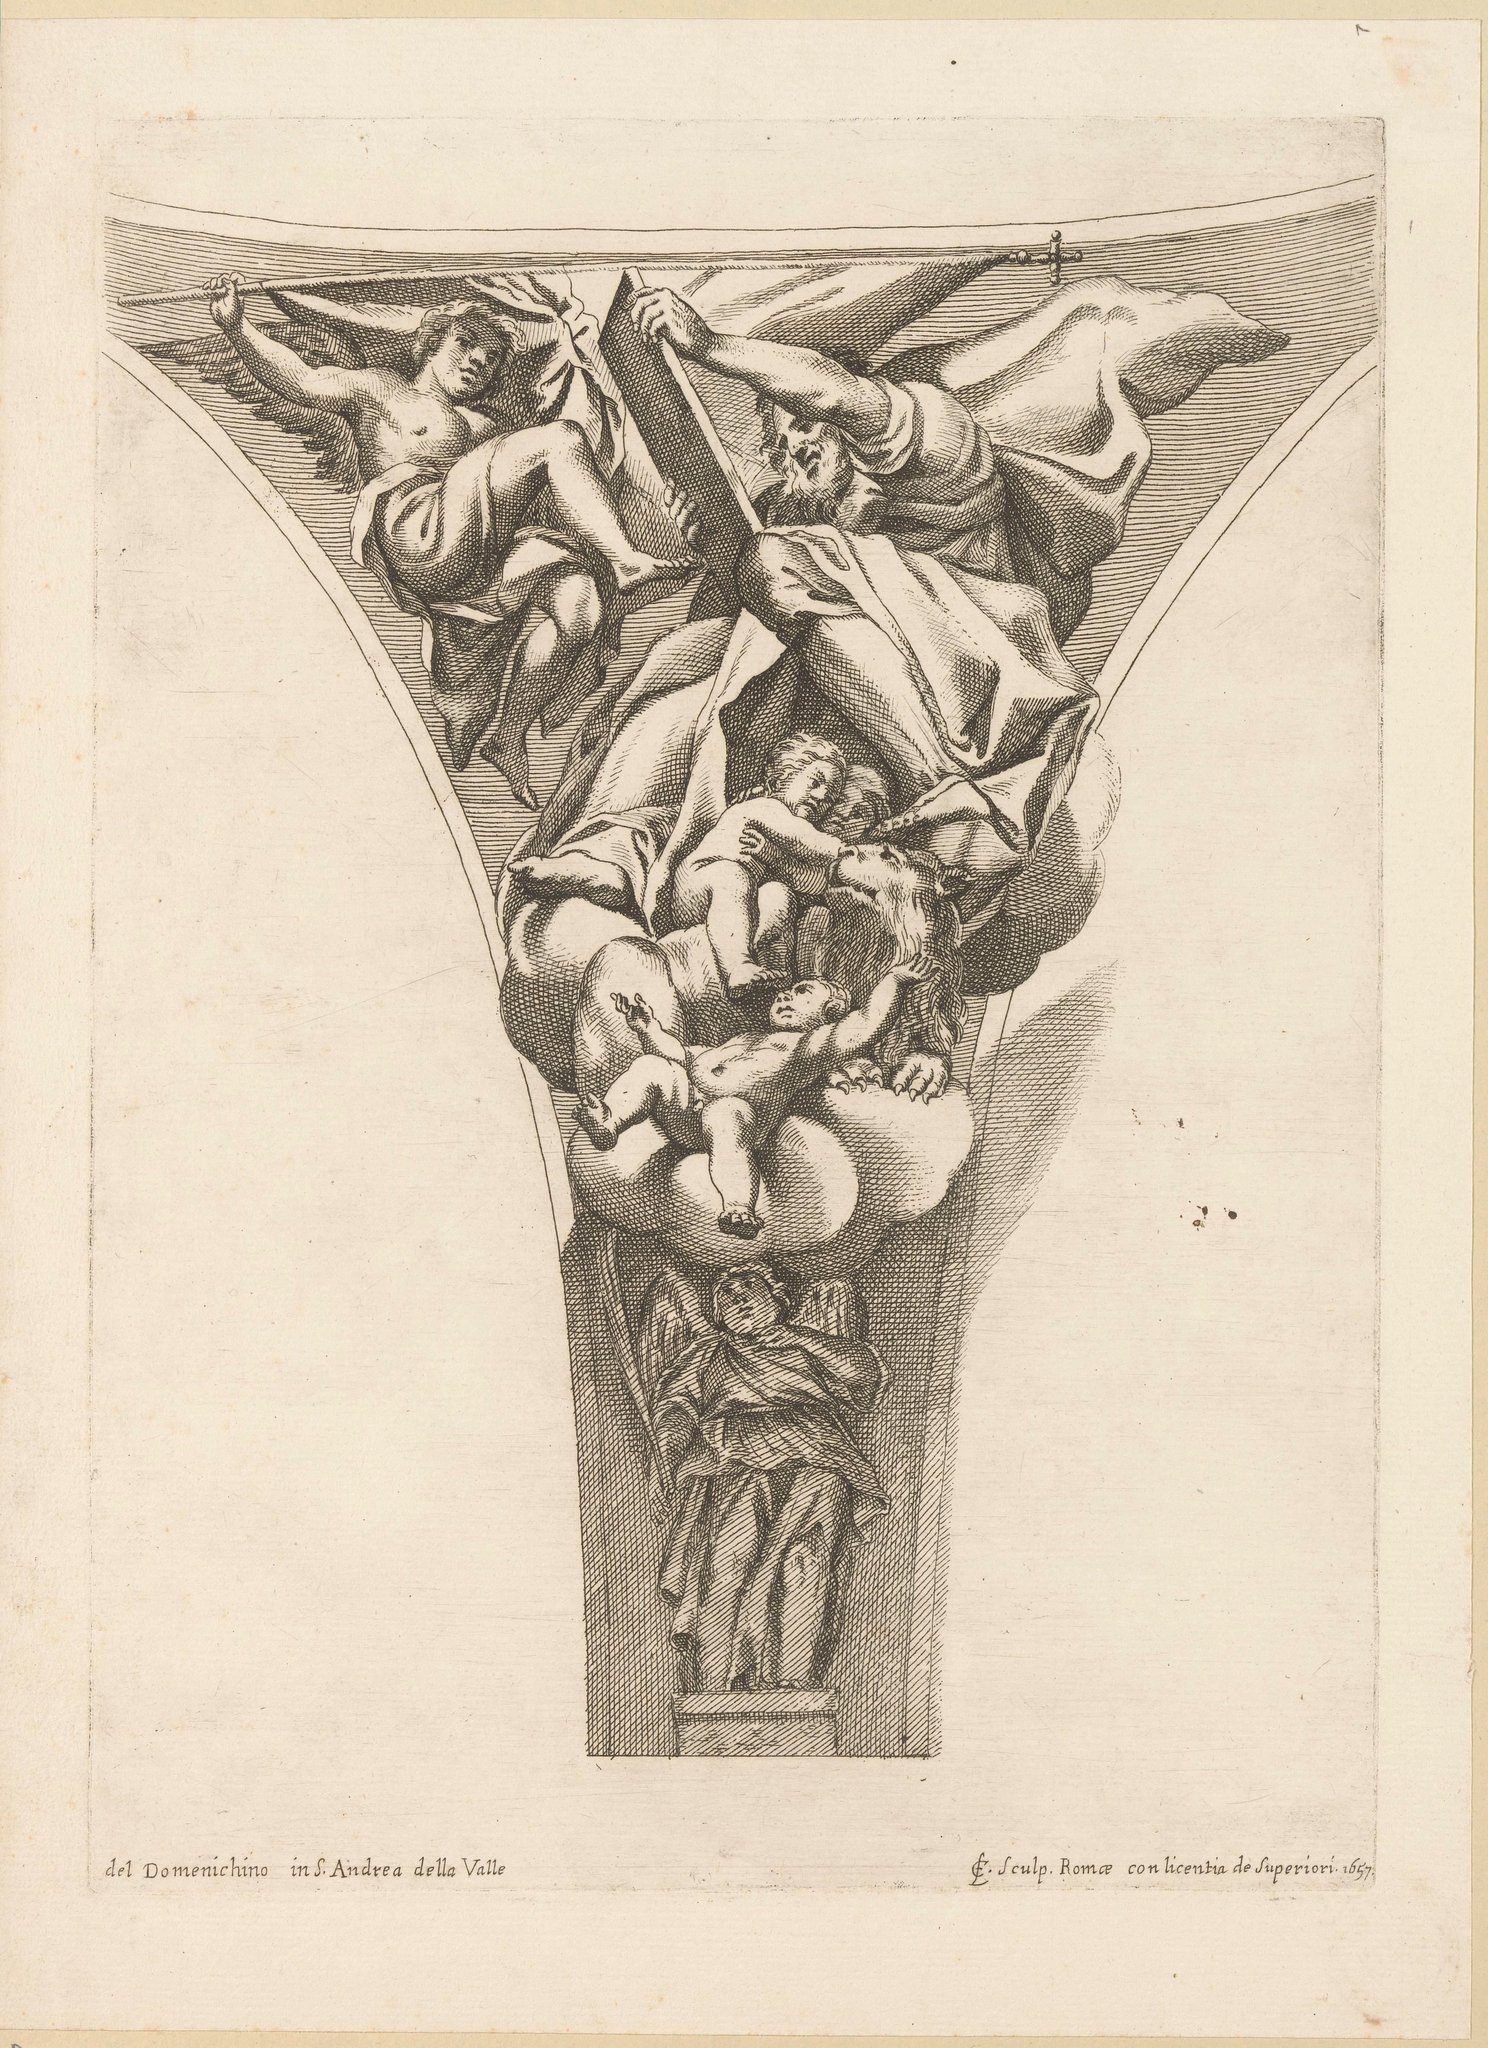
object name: print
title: Marcus de evangelist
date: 1657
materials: paper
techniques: etching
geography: rome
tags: mark (marcus) the evangelist, and bishop of alexandria; possible attributes: book, (winged) lion, pen and inkhorn, scroll, beasts of prey, predatory animals: lion, angels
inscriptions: collector's mark: Lugt 240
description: Prent naar fresco in de Sant'Andrea della Valle in Rome.